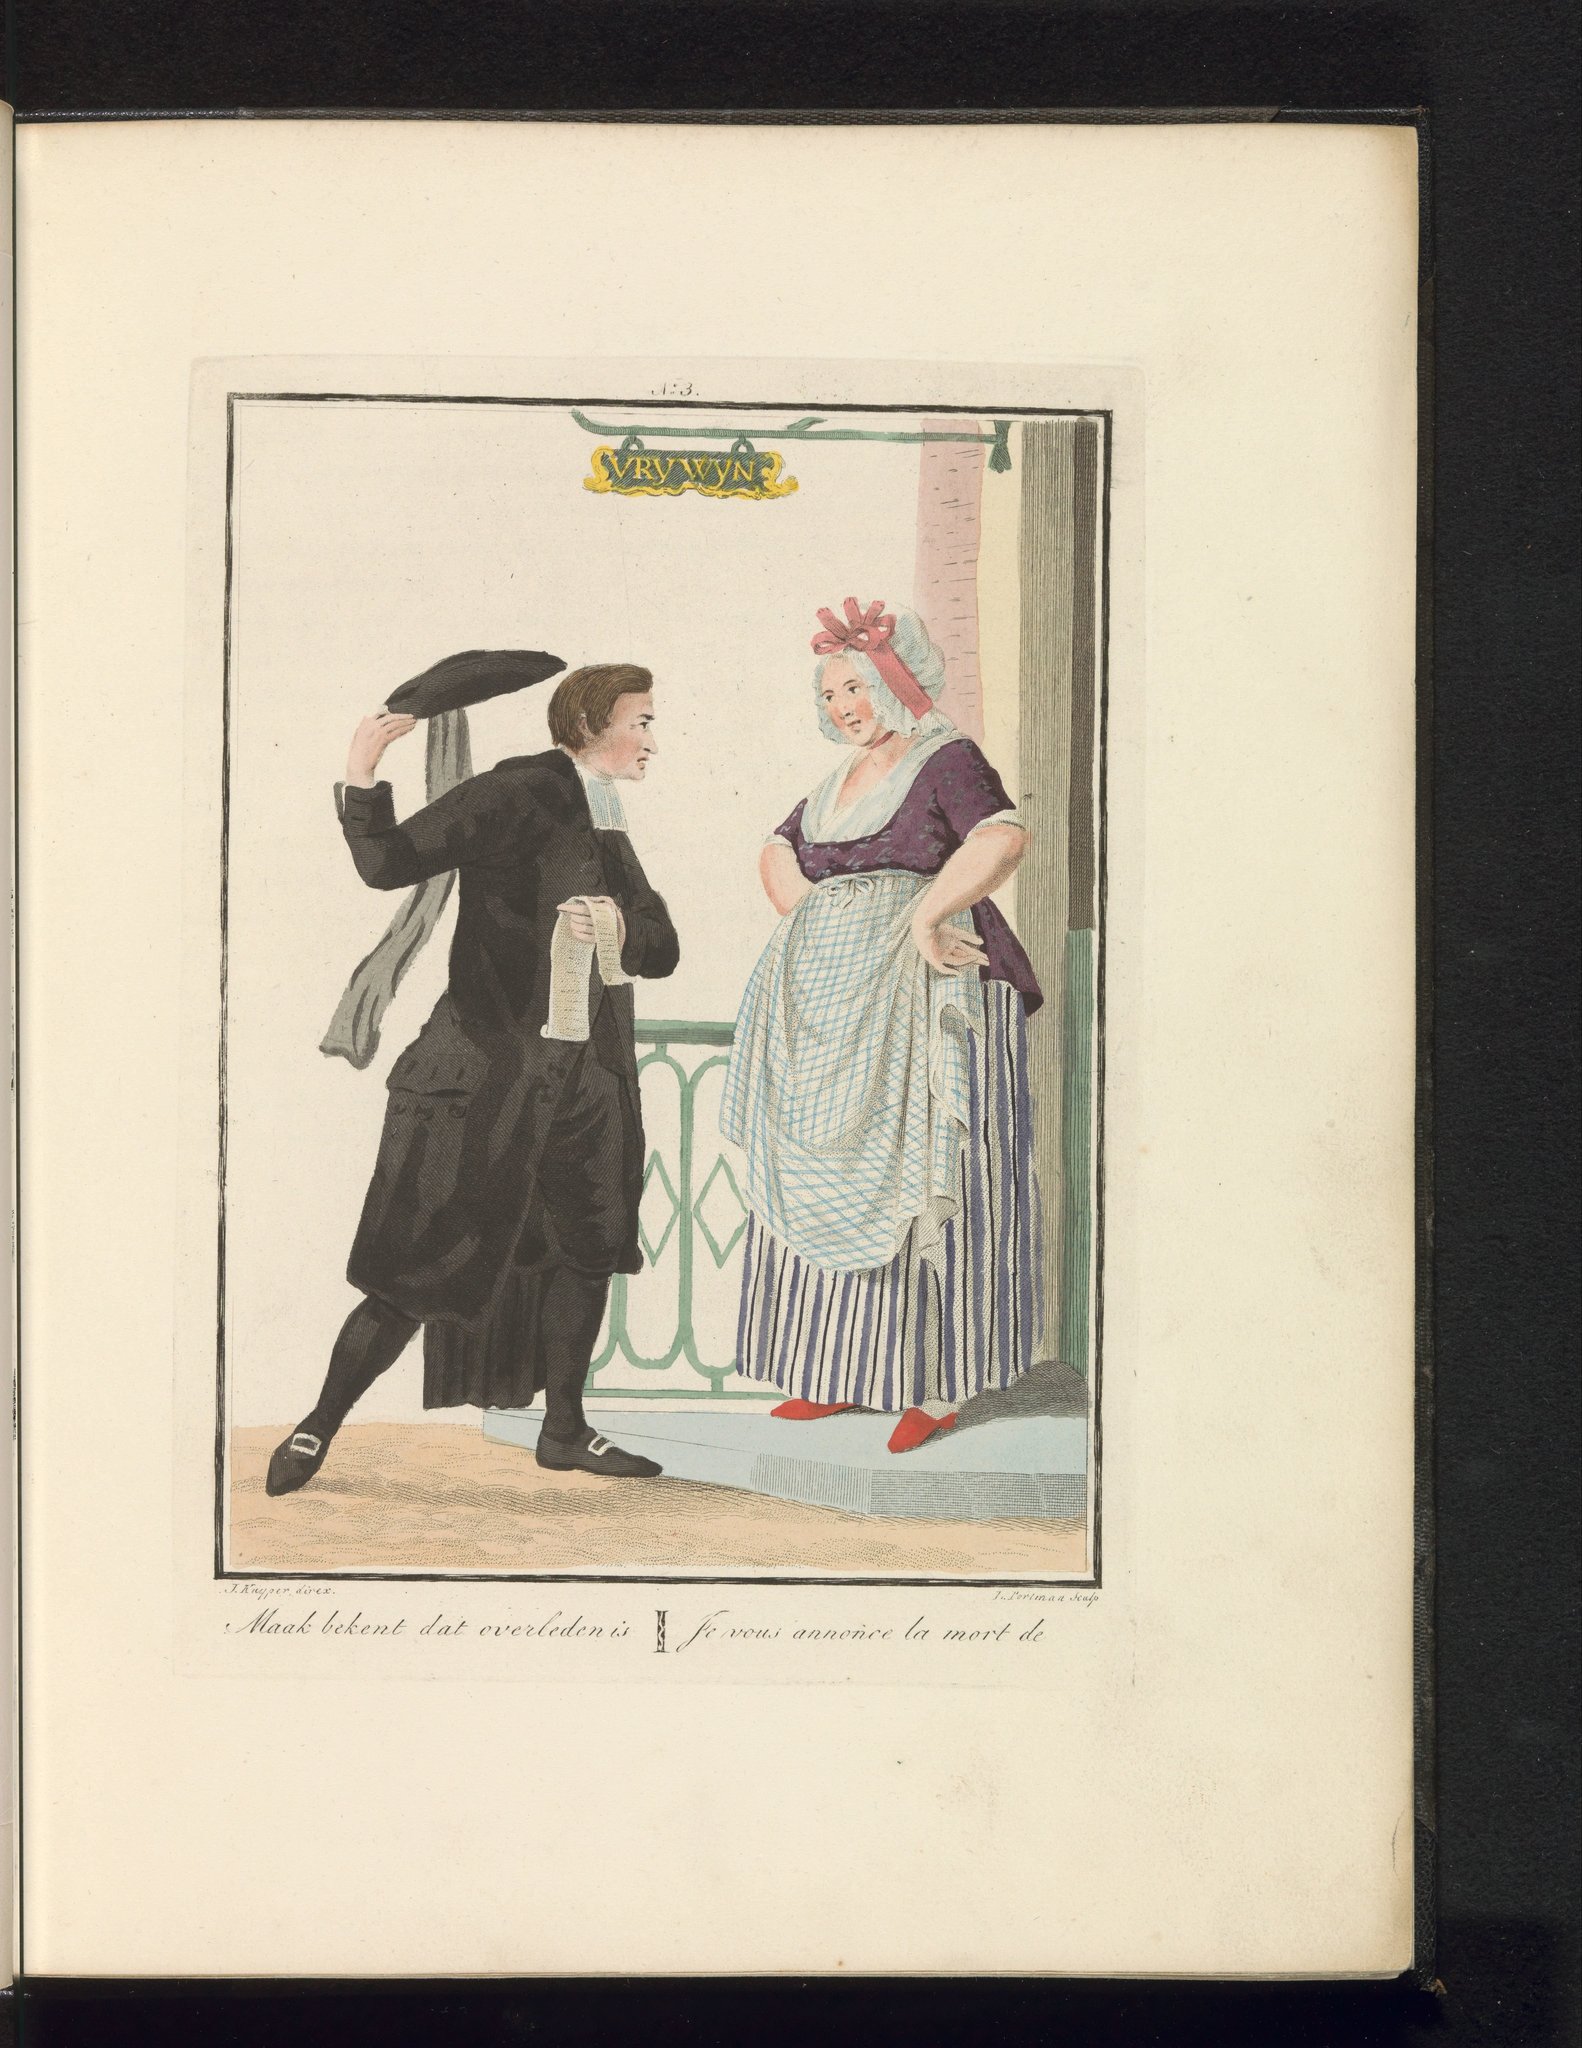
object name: print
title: Maak bekent dat overleden is / Je vous annonce la mort de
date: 1803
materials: paper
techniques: etching, hand coloring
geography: netherlands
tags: oral announcement (of death), undertaker's man, clothes, costume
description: Gebruikt als illustratie in: Evert Maaskamp, Afbeeldingen van de kleedingen, zeden en gewoonten in de noordelijke provincien van het Koningrijk der Nederlanden, met den aanvang der negentiende eeuw = Tableaux des habillemens, mœurs et coutumes dans les provinces septentrionales du Royaume des Pays-Bas, au commencement du dix-neuvième siècle. Amsterdam: Evert Maaskamp, 1829 [heruitgave van de oorspronkelijke platen eerst verschenen in 1803-1807].